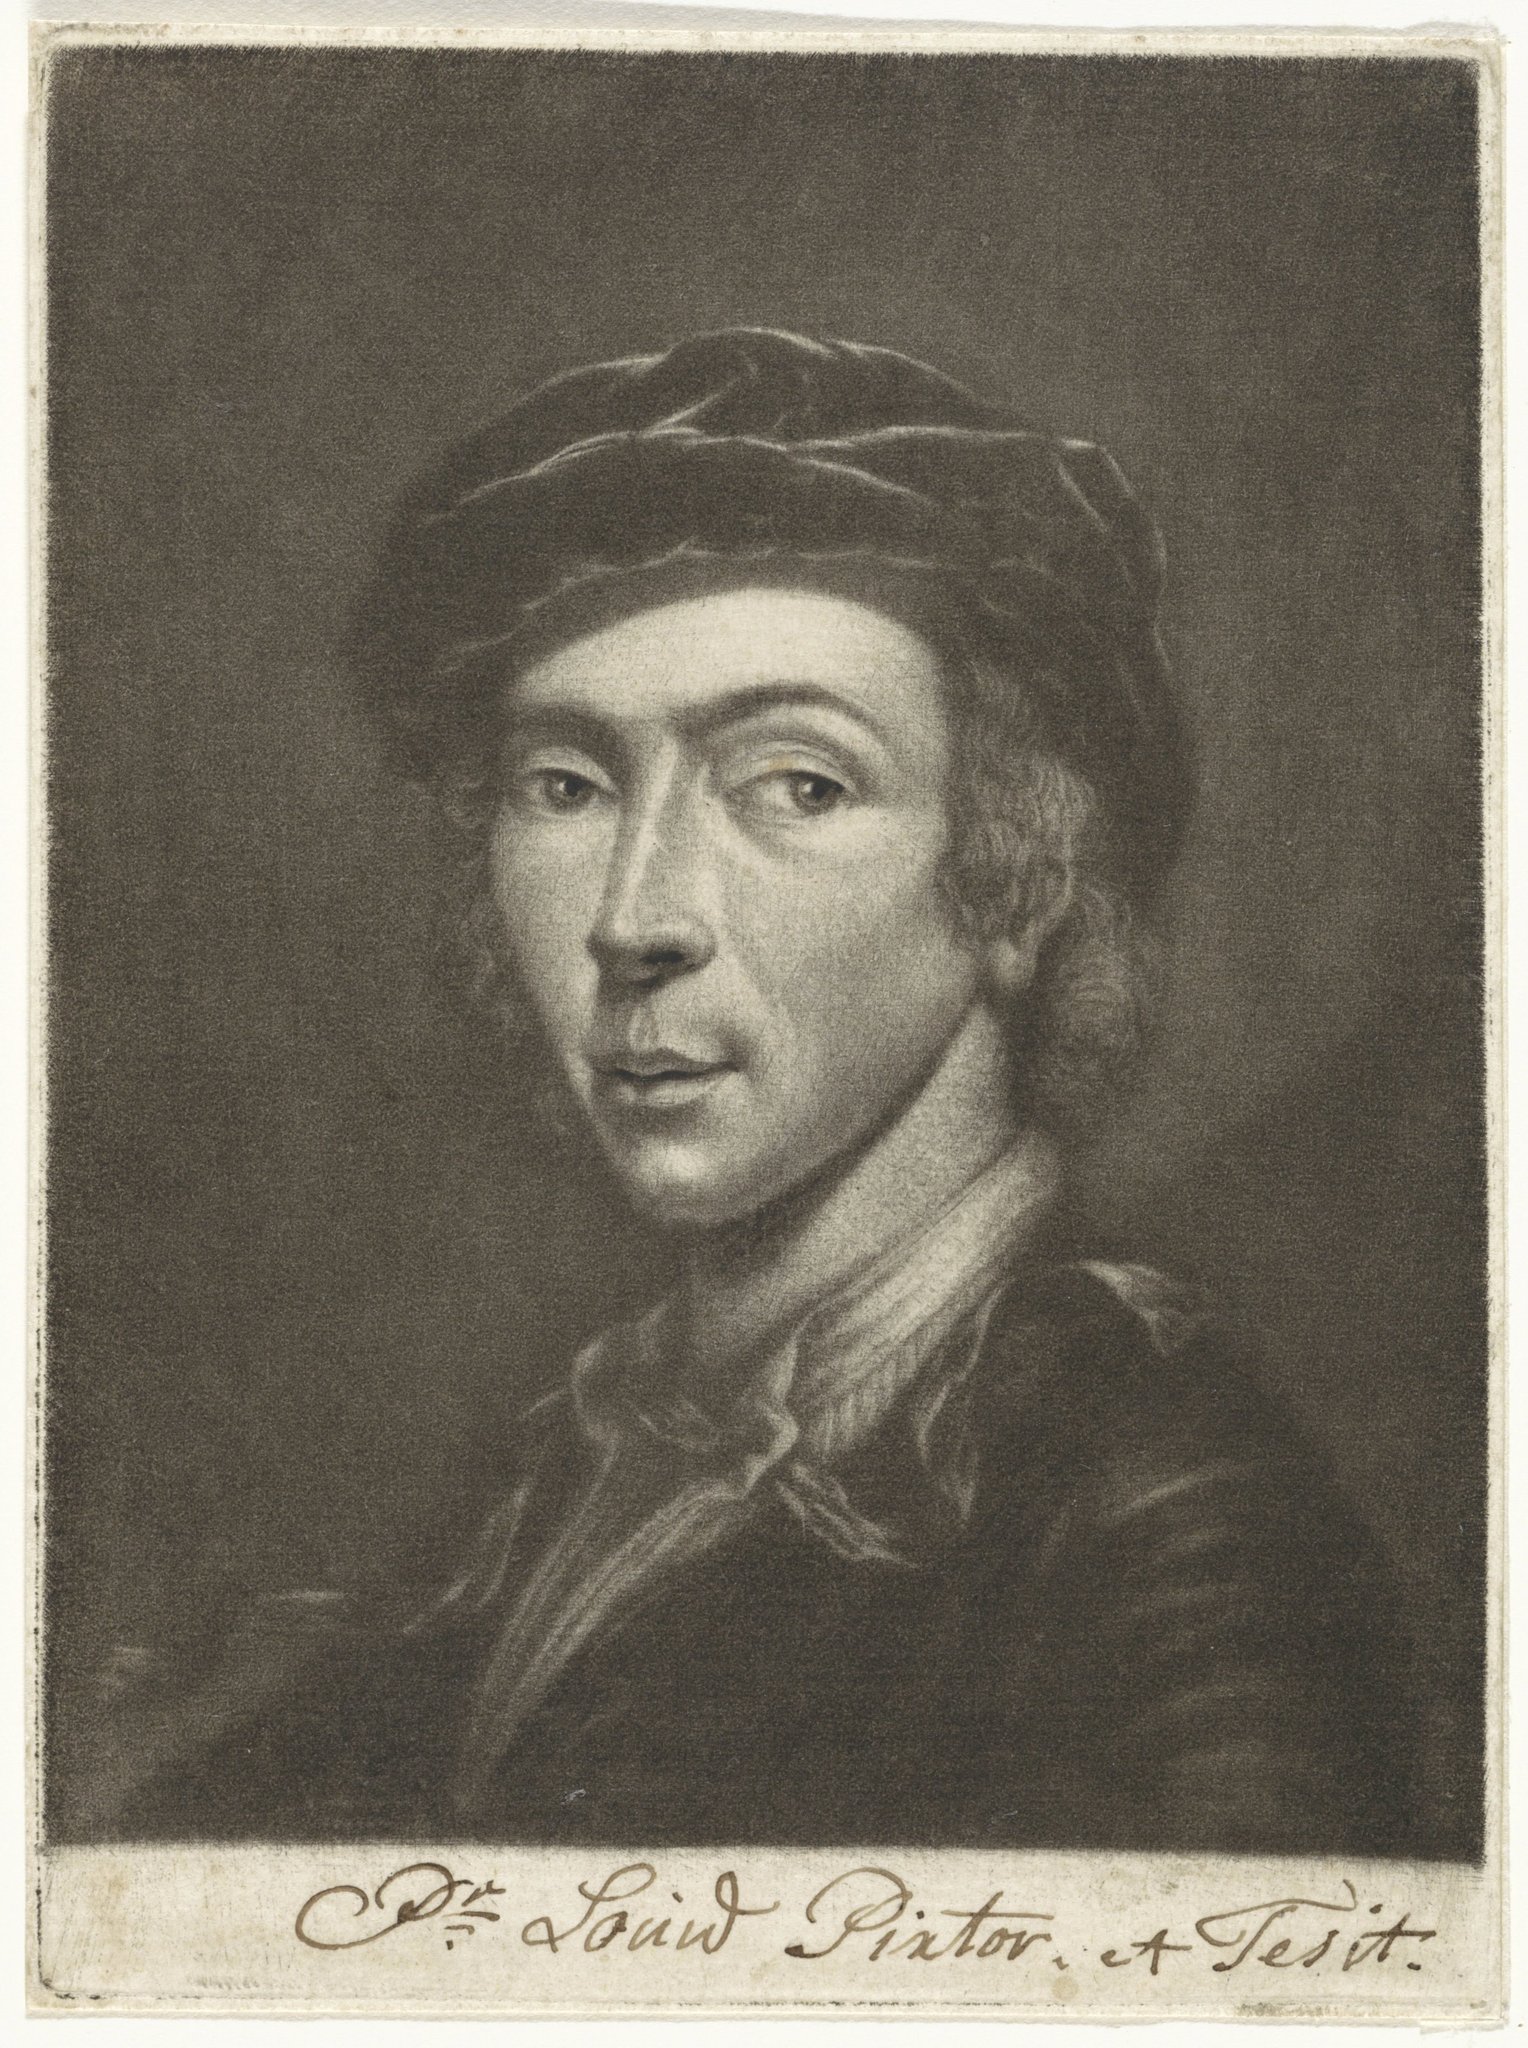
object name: print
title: Zelfportret van Pieter Louw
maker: pieter louw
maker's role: draughtsman, print maker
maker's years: 1725-1800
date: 1743-1760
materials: paper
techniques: pen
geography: amsterdam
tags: amsterdam, print maker, draughtsman, pieter louw, portrait, self-portrait of graphic artist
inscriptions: inscription: ‘P: Louw Pixtor A Fecit’, collector's mark: Lugt 2165, collector's mark: Lugt 2228